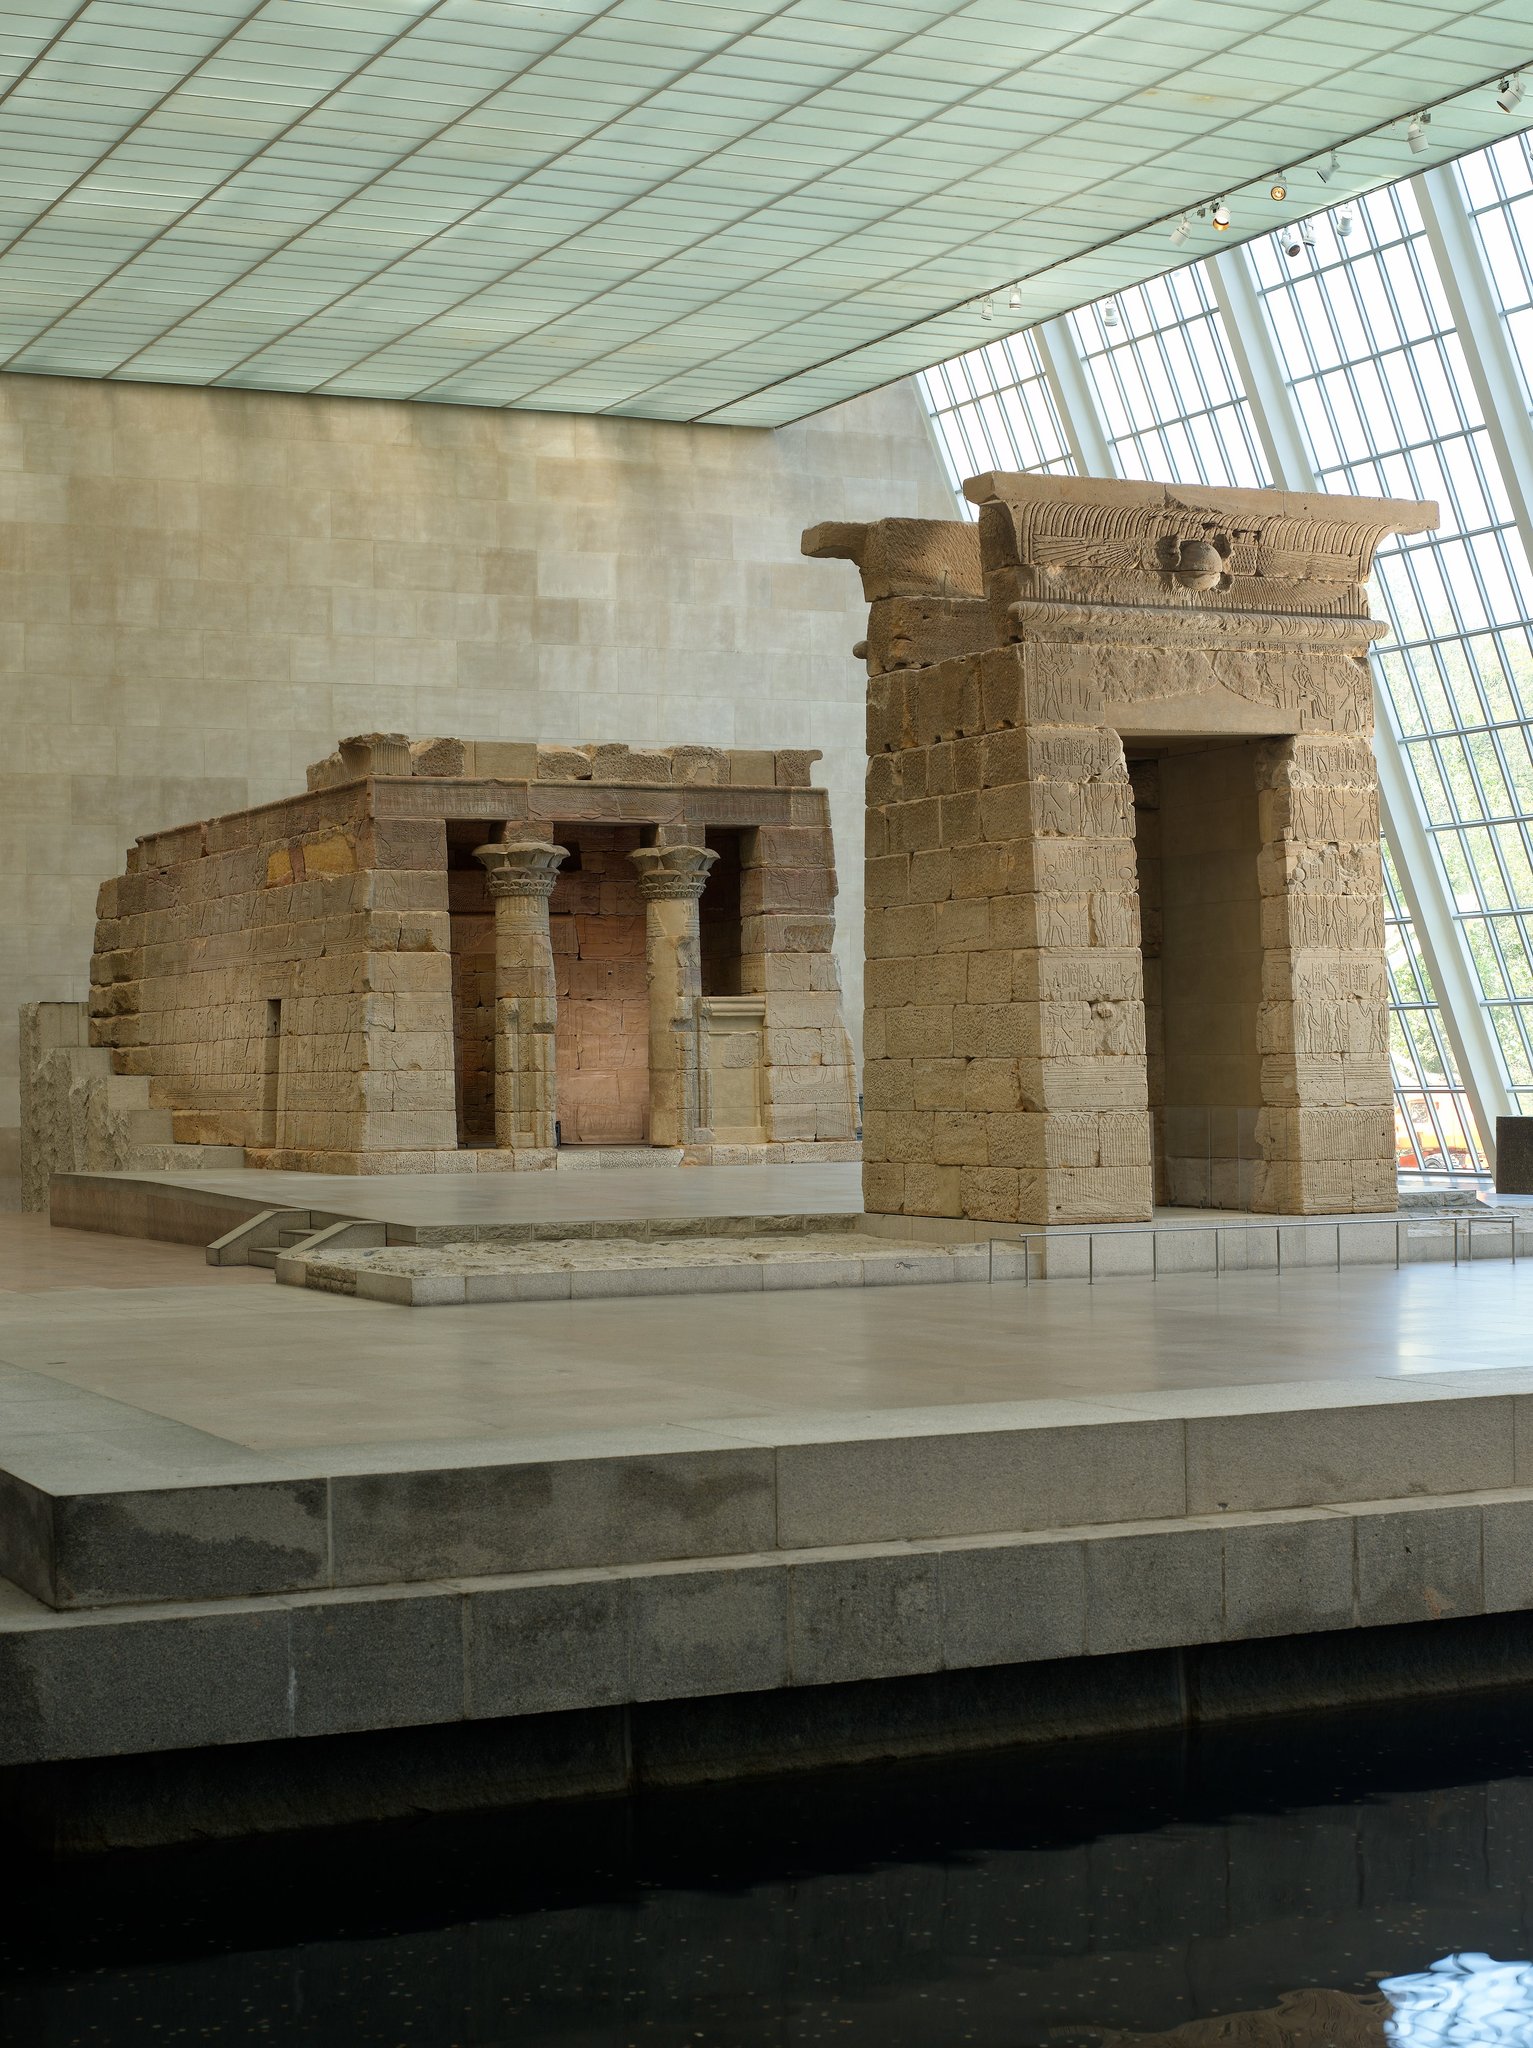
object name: temple, dendur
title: The Temple of Dendur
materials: stone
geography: nubia